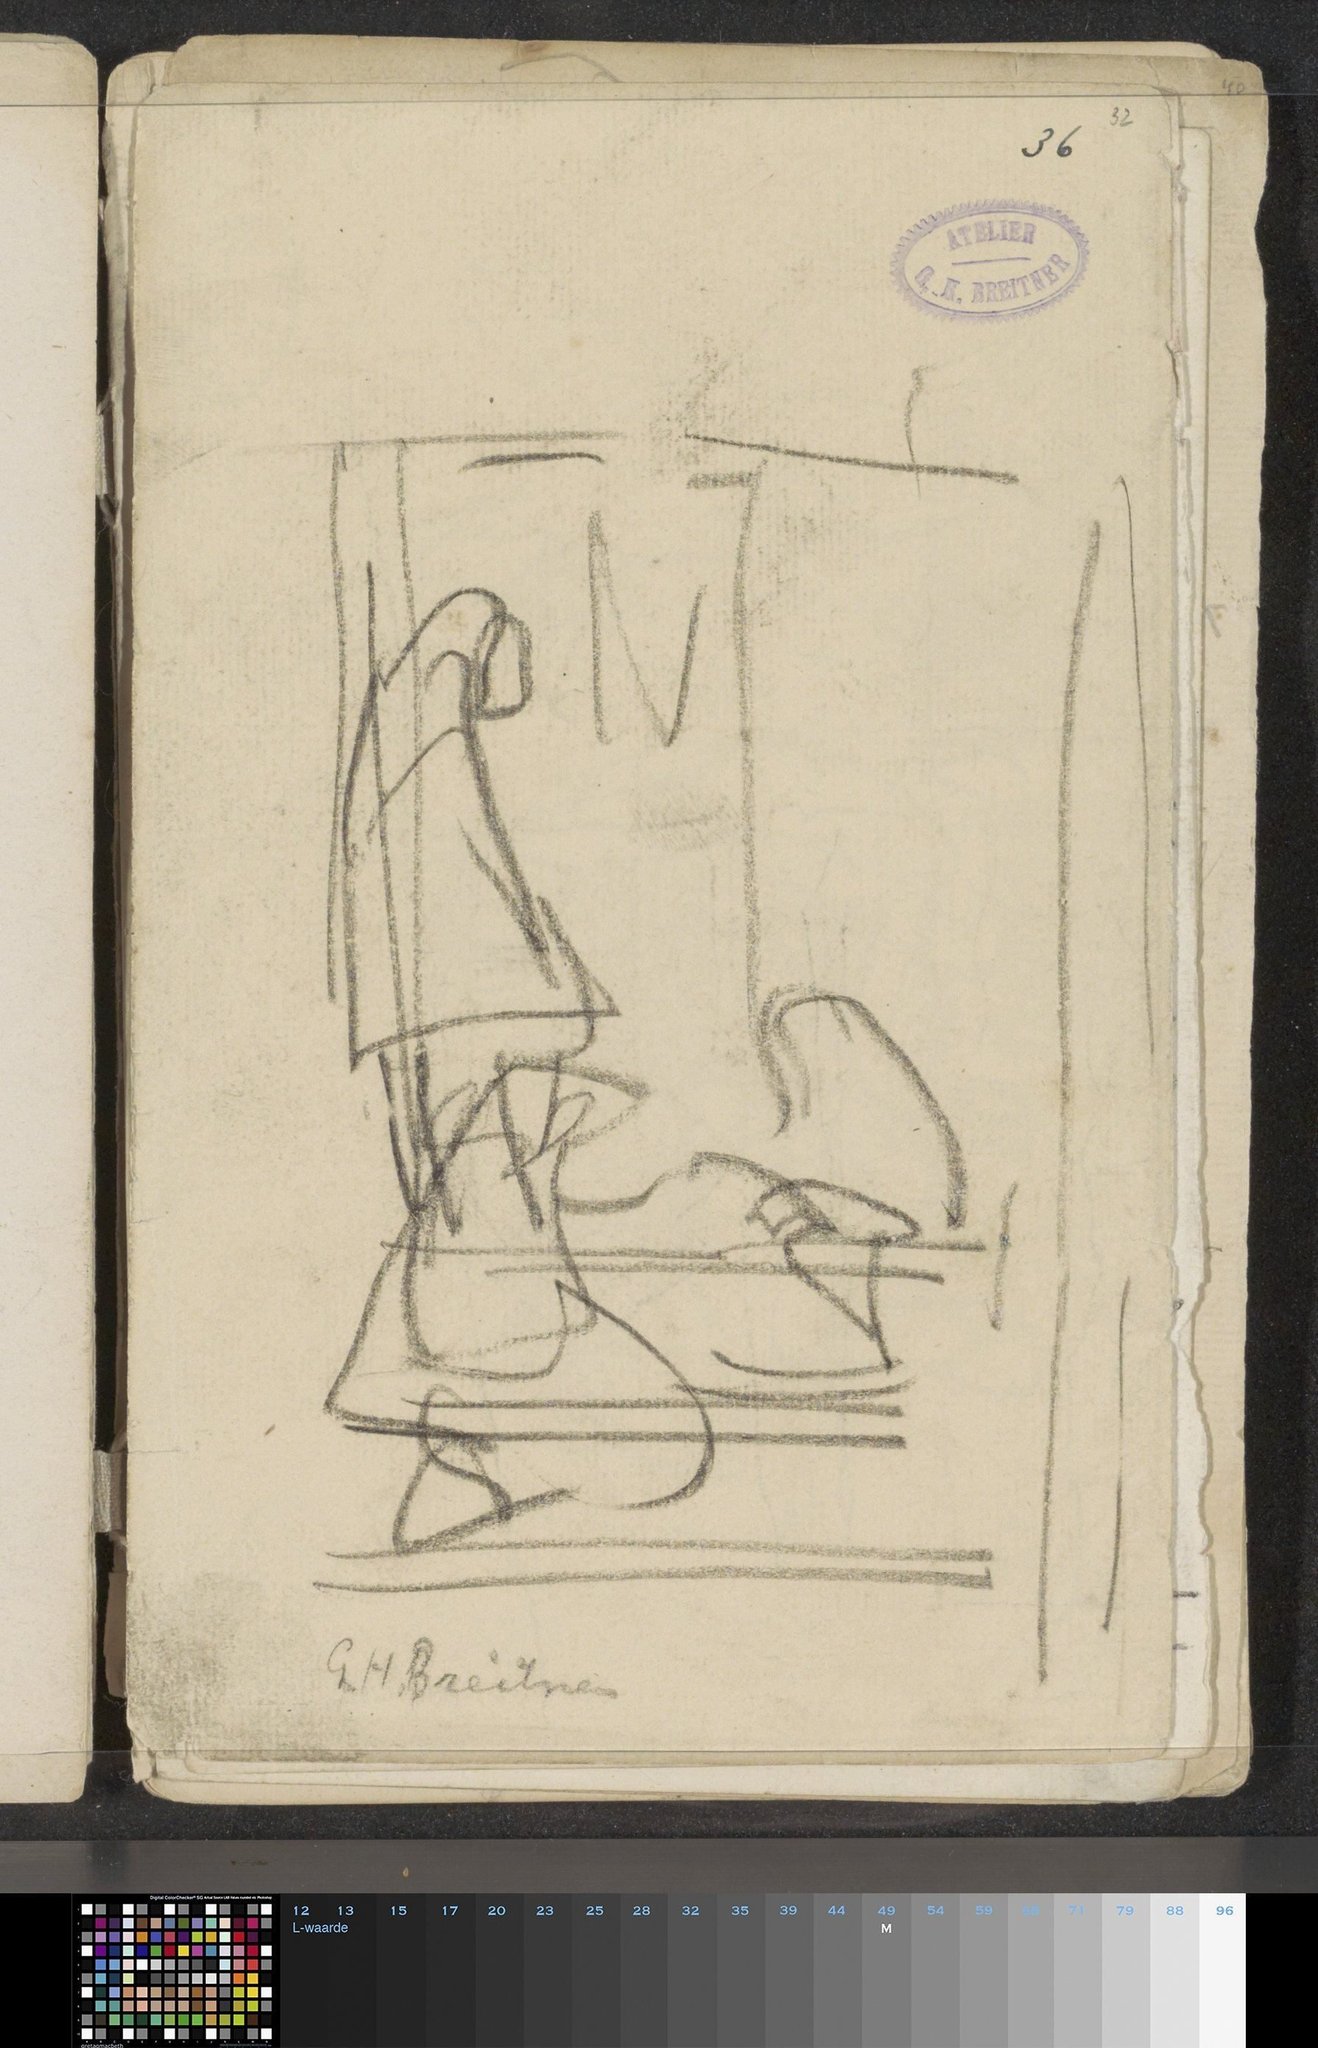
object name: sketchbook leaf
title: Studie, mogelijk van twee vrouwen op een trap voor een huis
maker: george hendrik breitner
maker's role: draughtsman, painter, print maker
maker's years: 1857-1923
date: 1886-1923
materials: chalk, paper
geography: amsterdam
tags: urban housing, adult woman (+ two persons), front steps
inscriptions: signature: ‘G.H. Breitner’, workshop stamp: Lugt 291d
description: Pagina 32 uit een schetsboek met 19 bladen en 9 losse tekeningen.